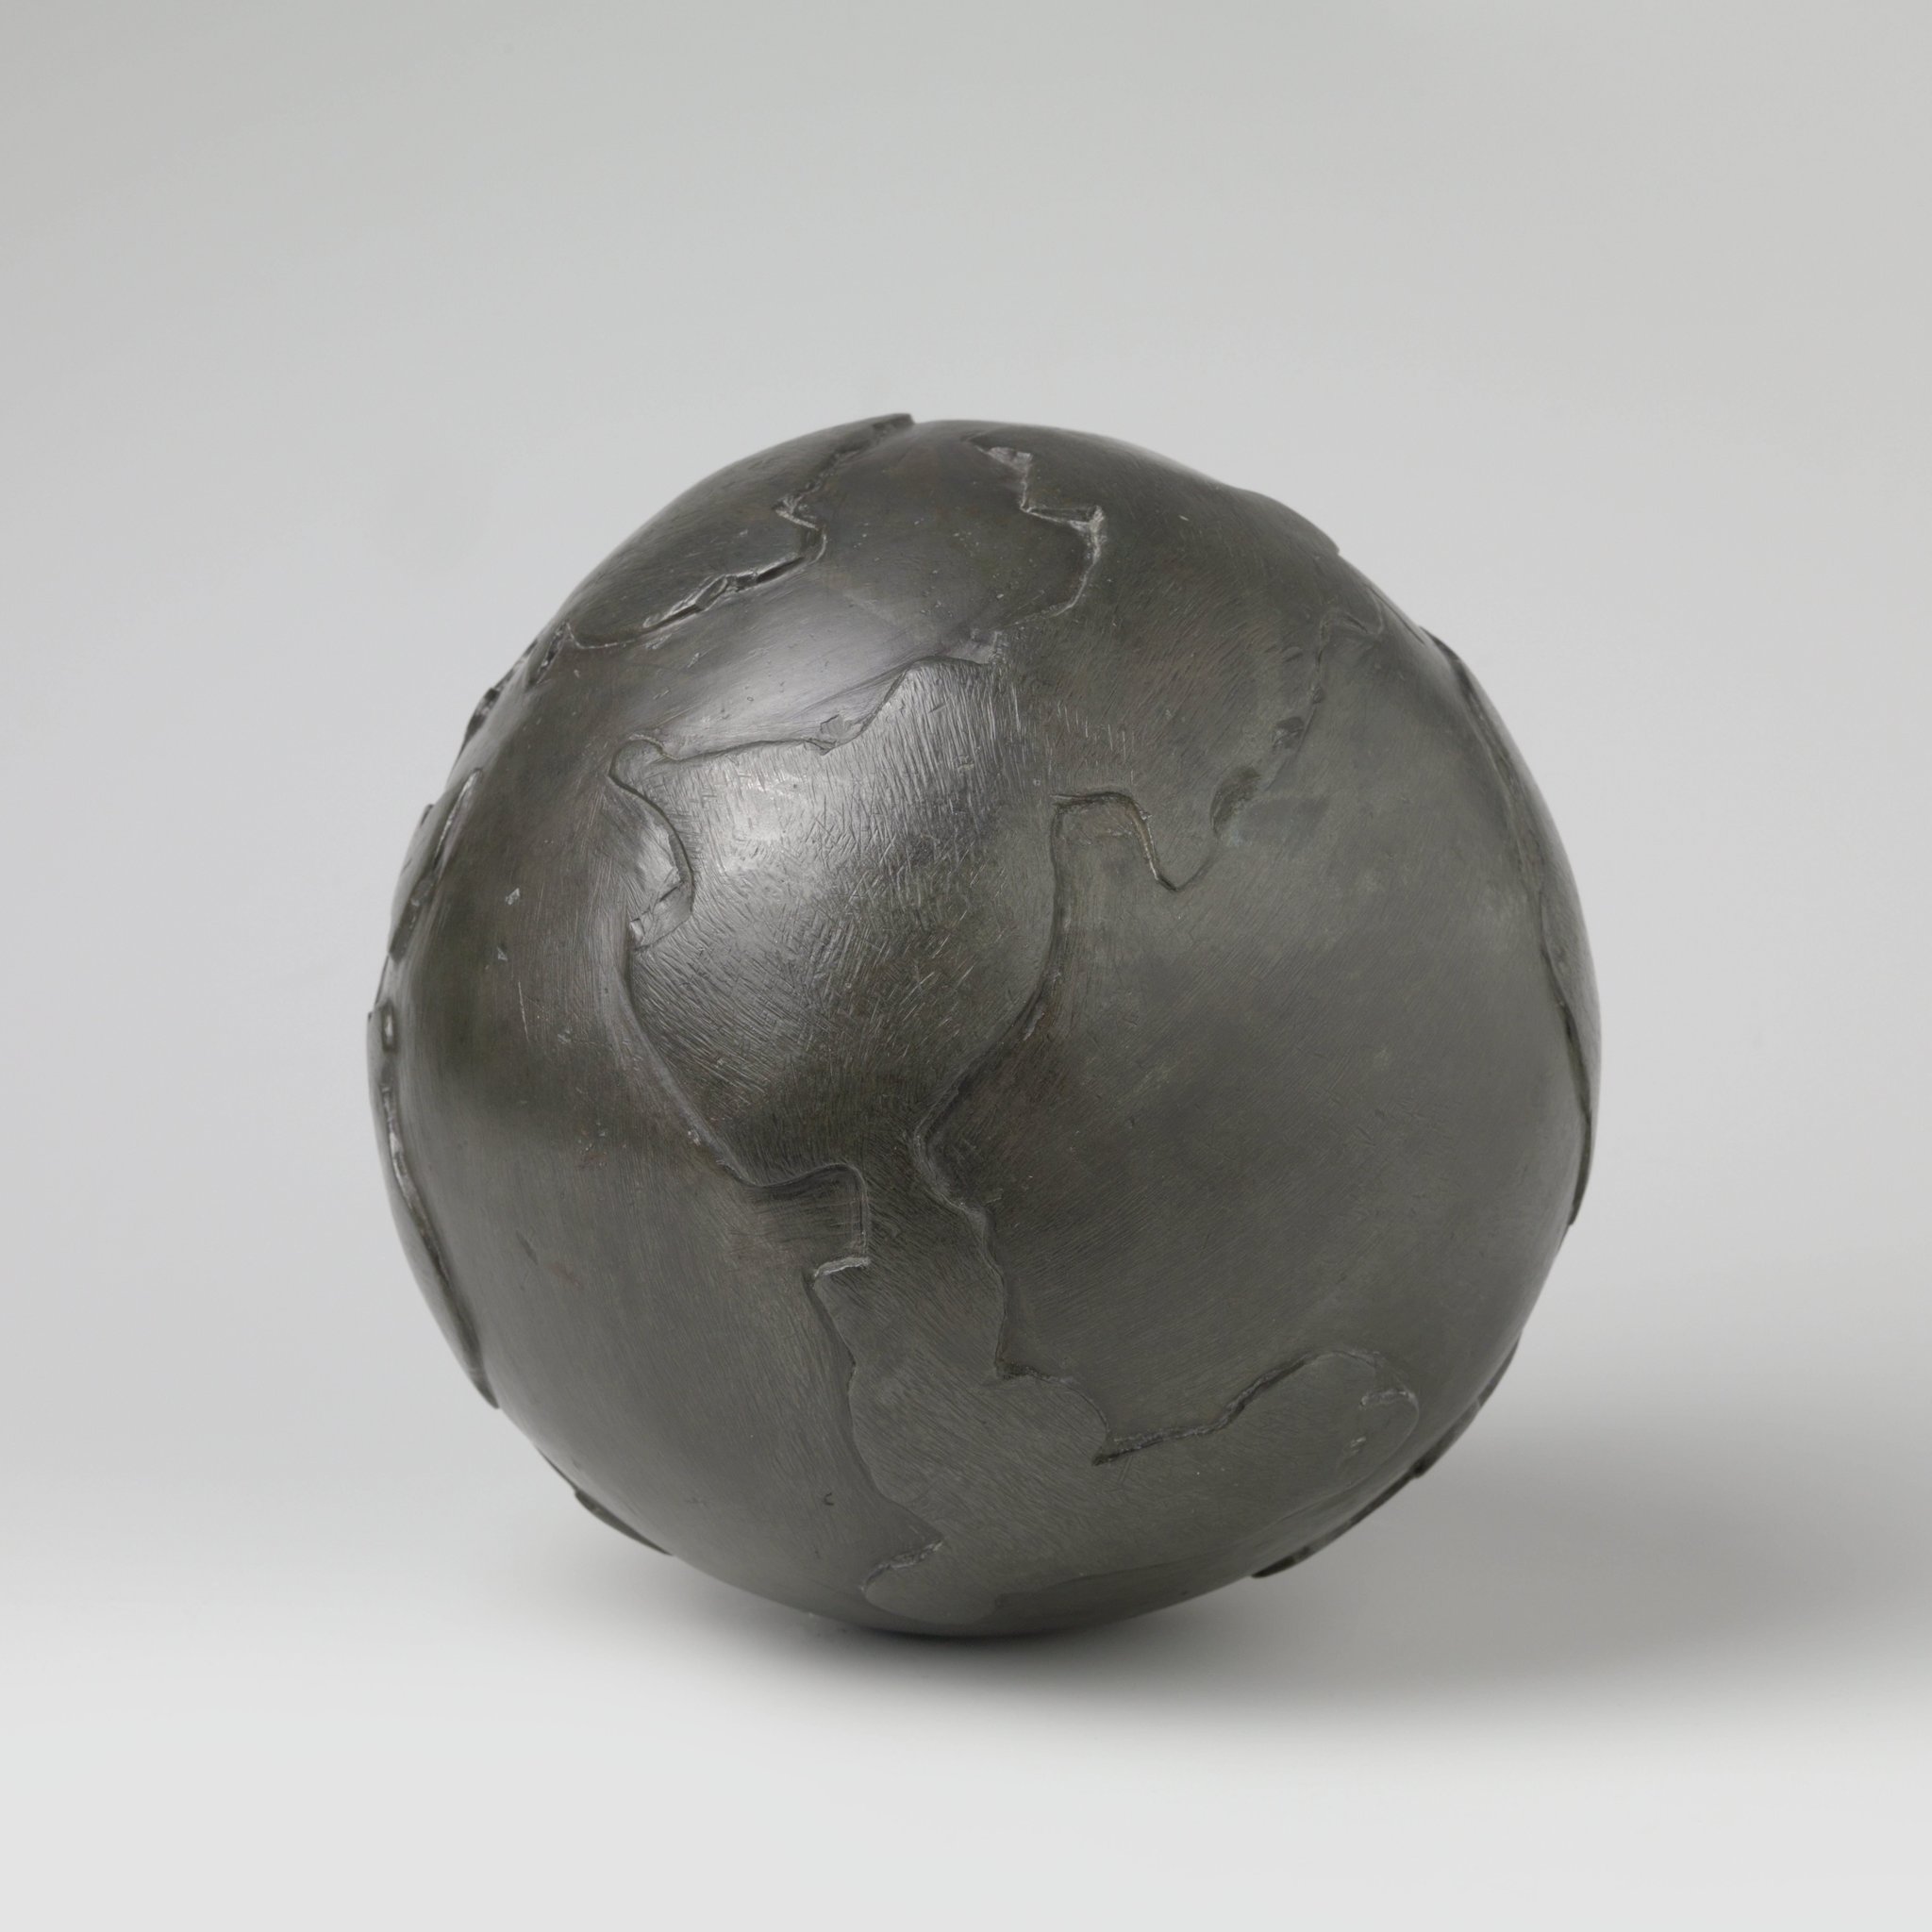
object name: globe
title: Bacchant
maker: Anonymous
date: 1626-1699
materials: bronze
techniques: casting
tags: male bacchant(es)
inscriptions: signature and date: ‘ADRIANVS FRIES 1626’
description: Globe. Latere toevoeging bij het beeld van een Bacchant (BK-2015-2-1). De wereldbol (of hemelgewelf) maakte het beeld tot Atlas of Hercules. De bol laat gefantaseerde continenten zien.